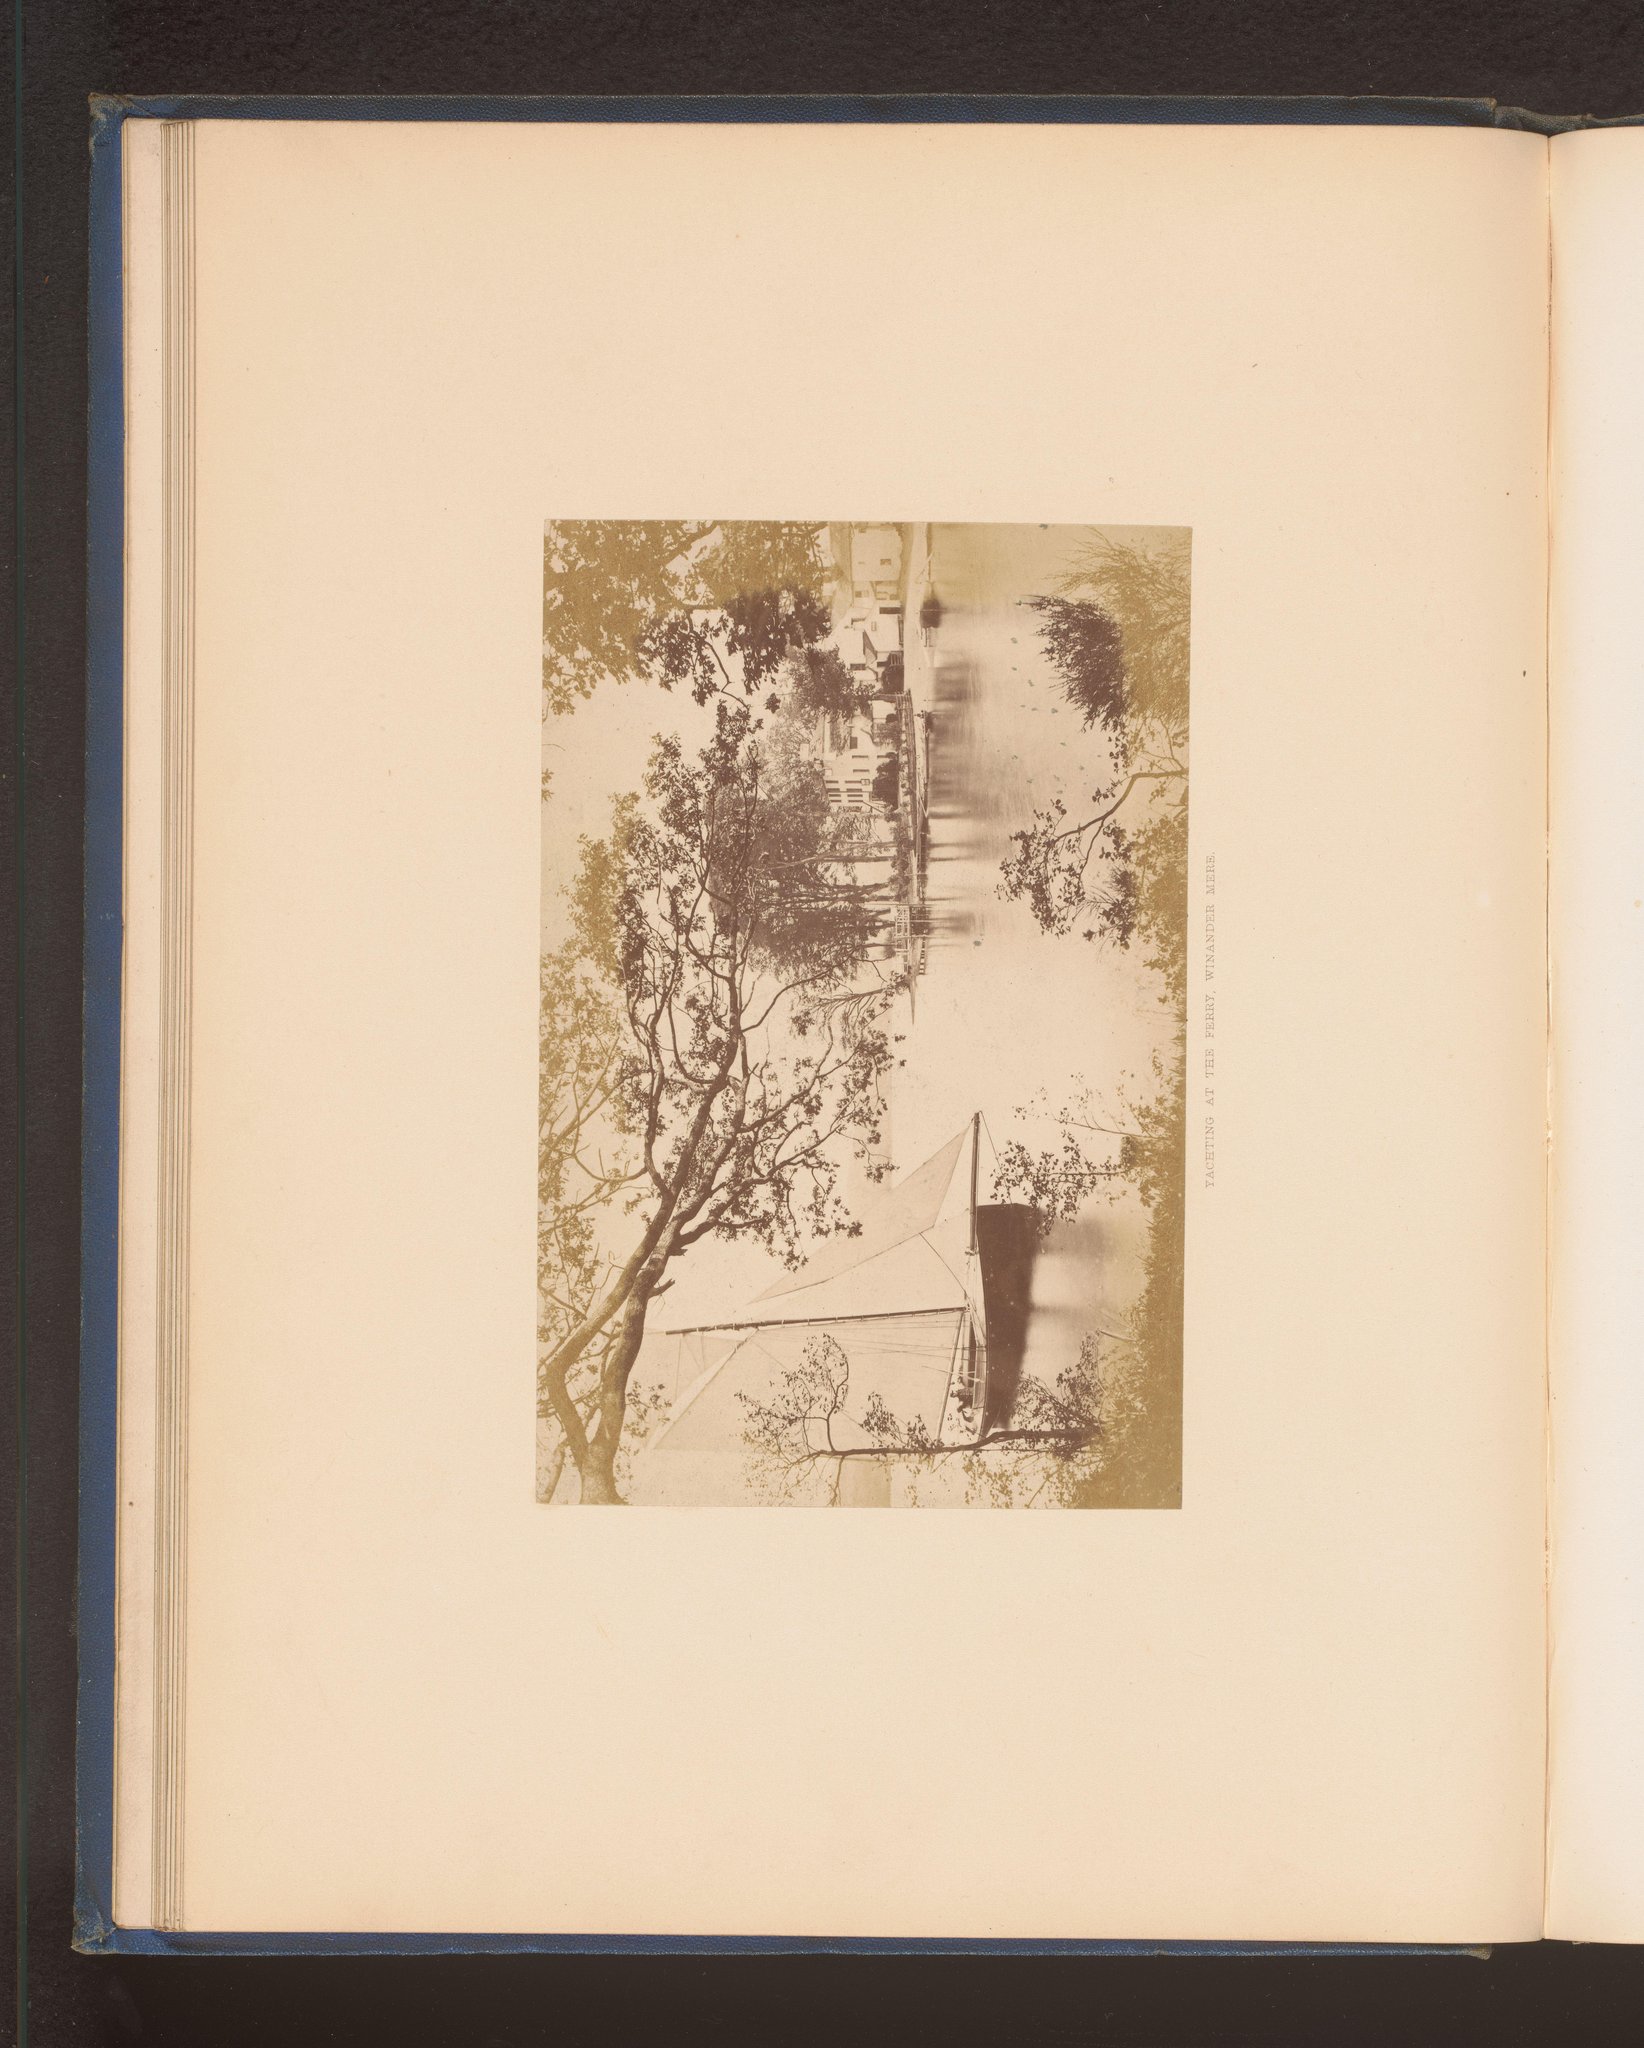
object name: page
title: Yachting at the Ferry, Winander Mere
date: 1857-1867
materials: photographic support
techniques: albumen print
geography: windermere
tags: sailing-ship, sailing-boat, cottage